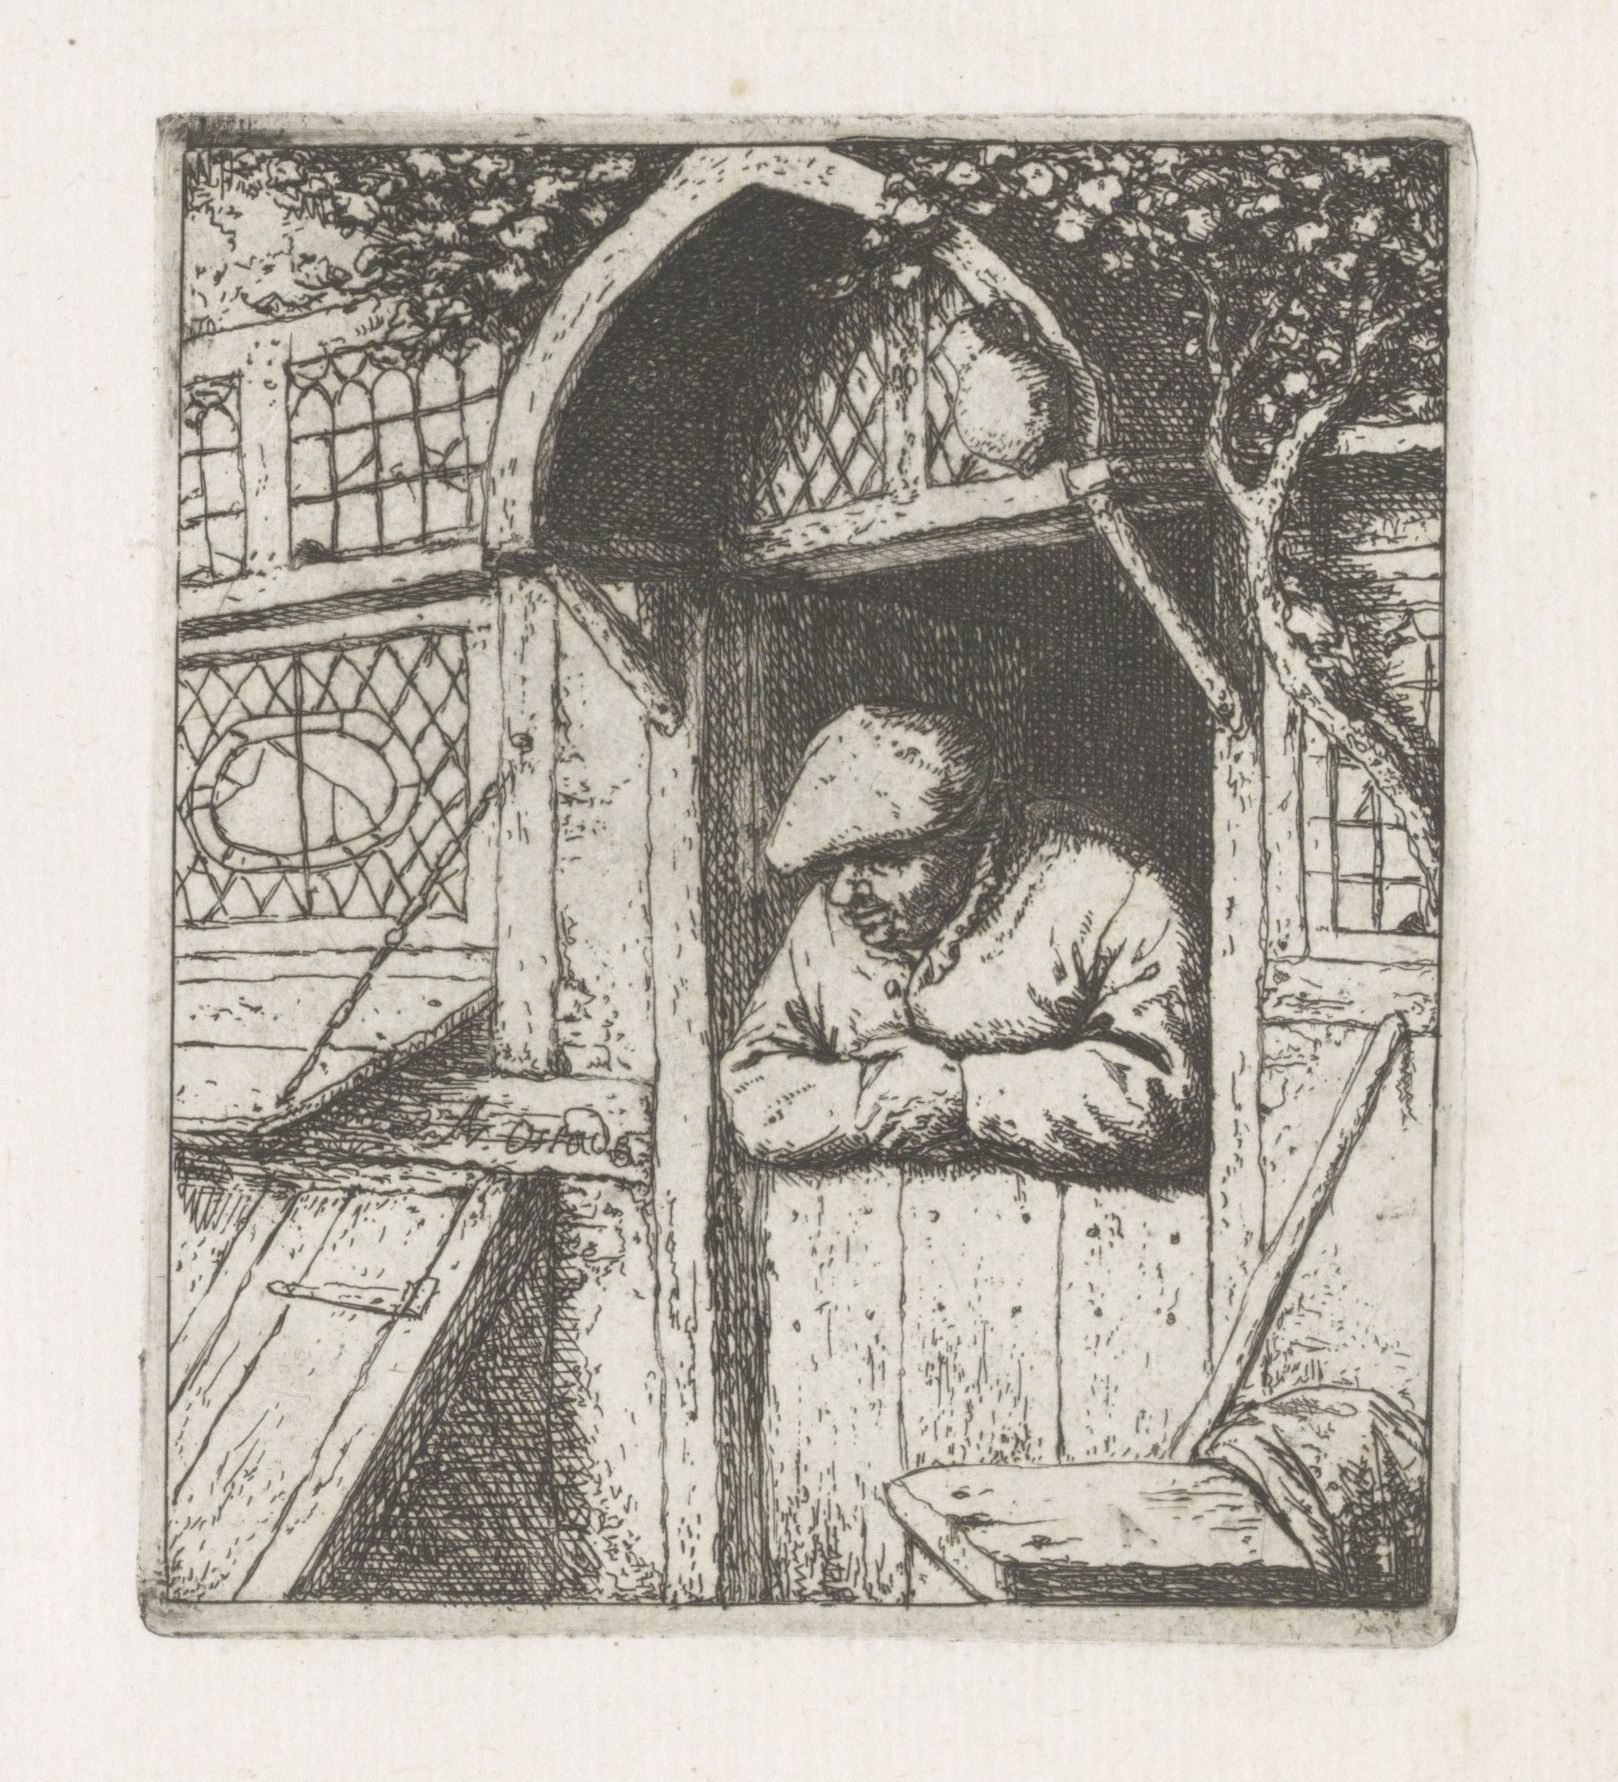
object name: print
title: Man leunt op een onderdeur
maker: adriaen van ostade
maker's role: draughtsman, painter, print maker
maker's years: 1610-1685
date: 1651-1655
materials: paper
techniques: etching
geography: haarlem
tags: divided door, upper part opened, adult man (+ leaning)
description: Deze prent maakt deel uit van een album.